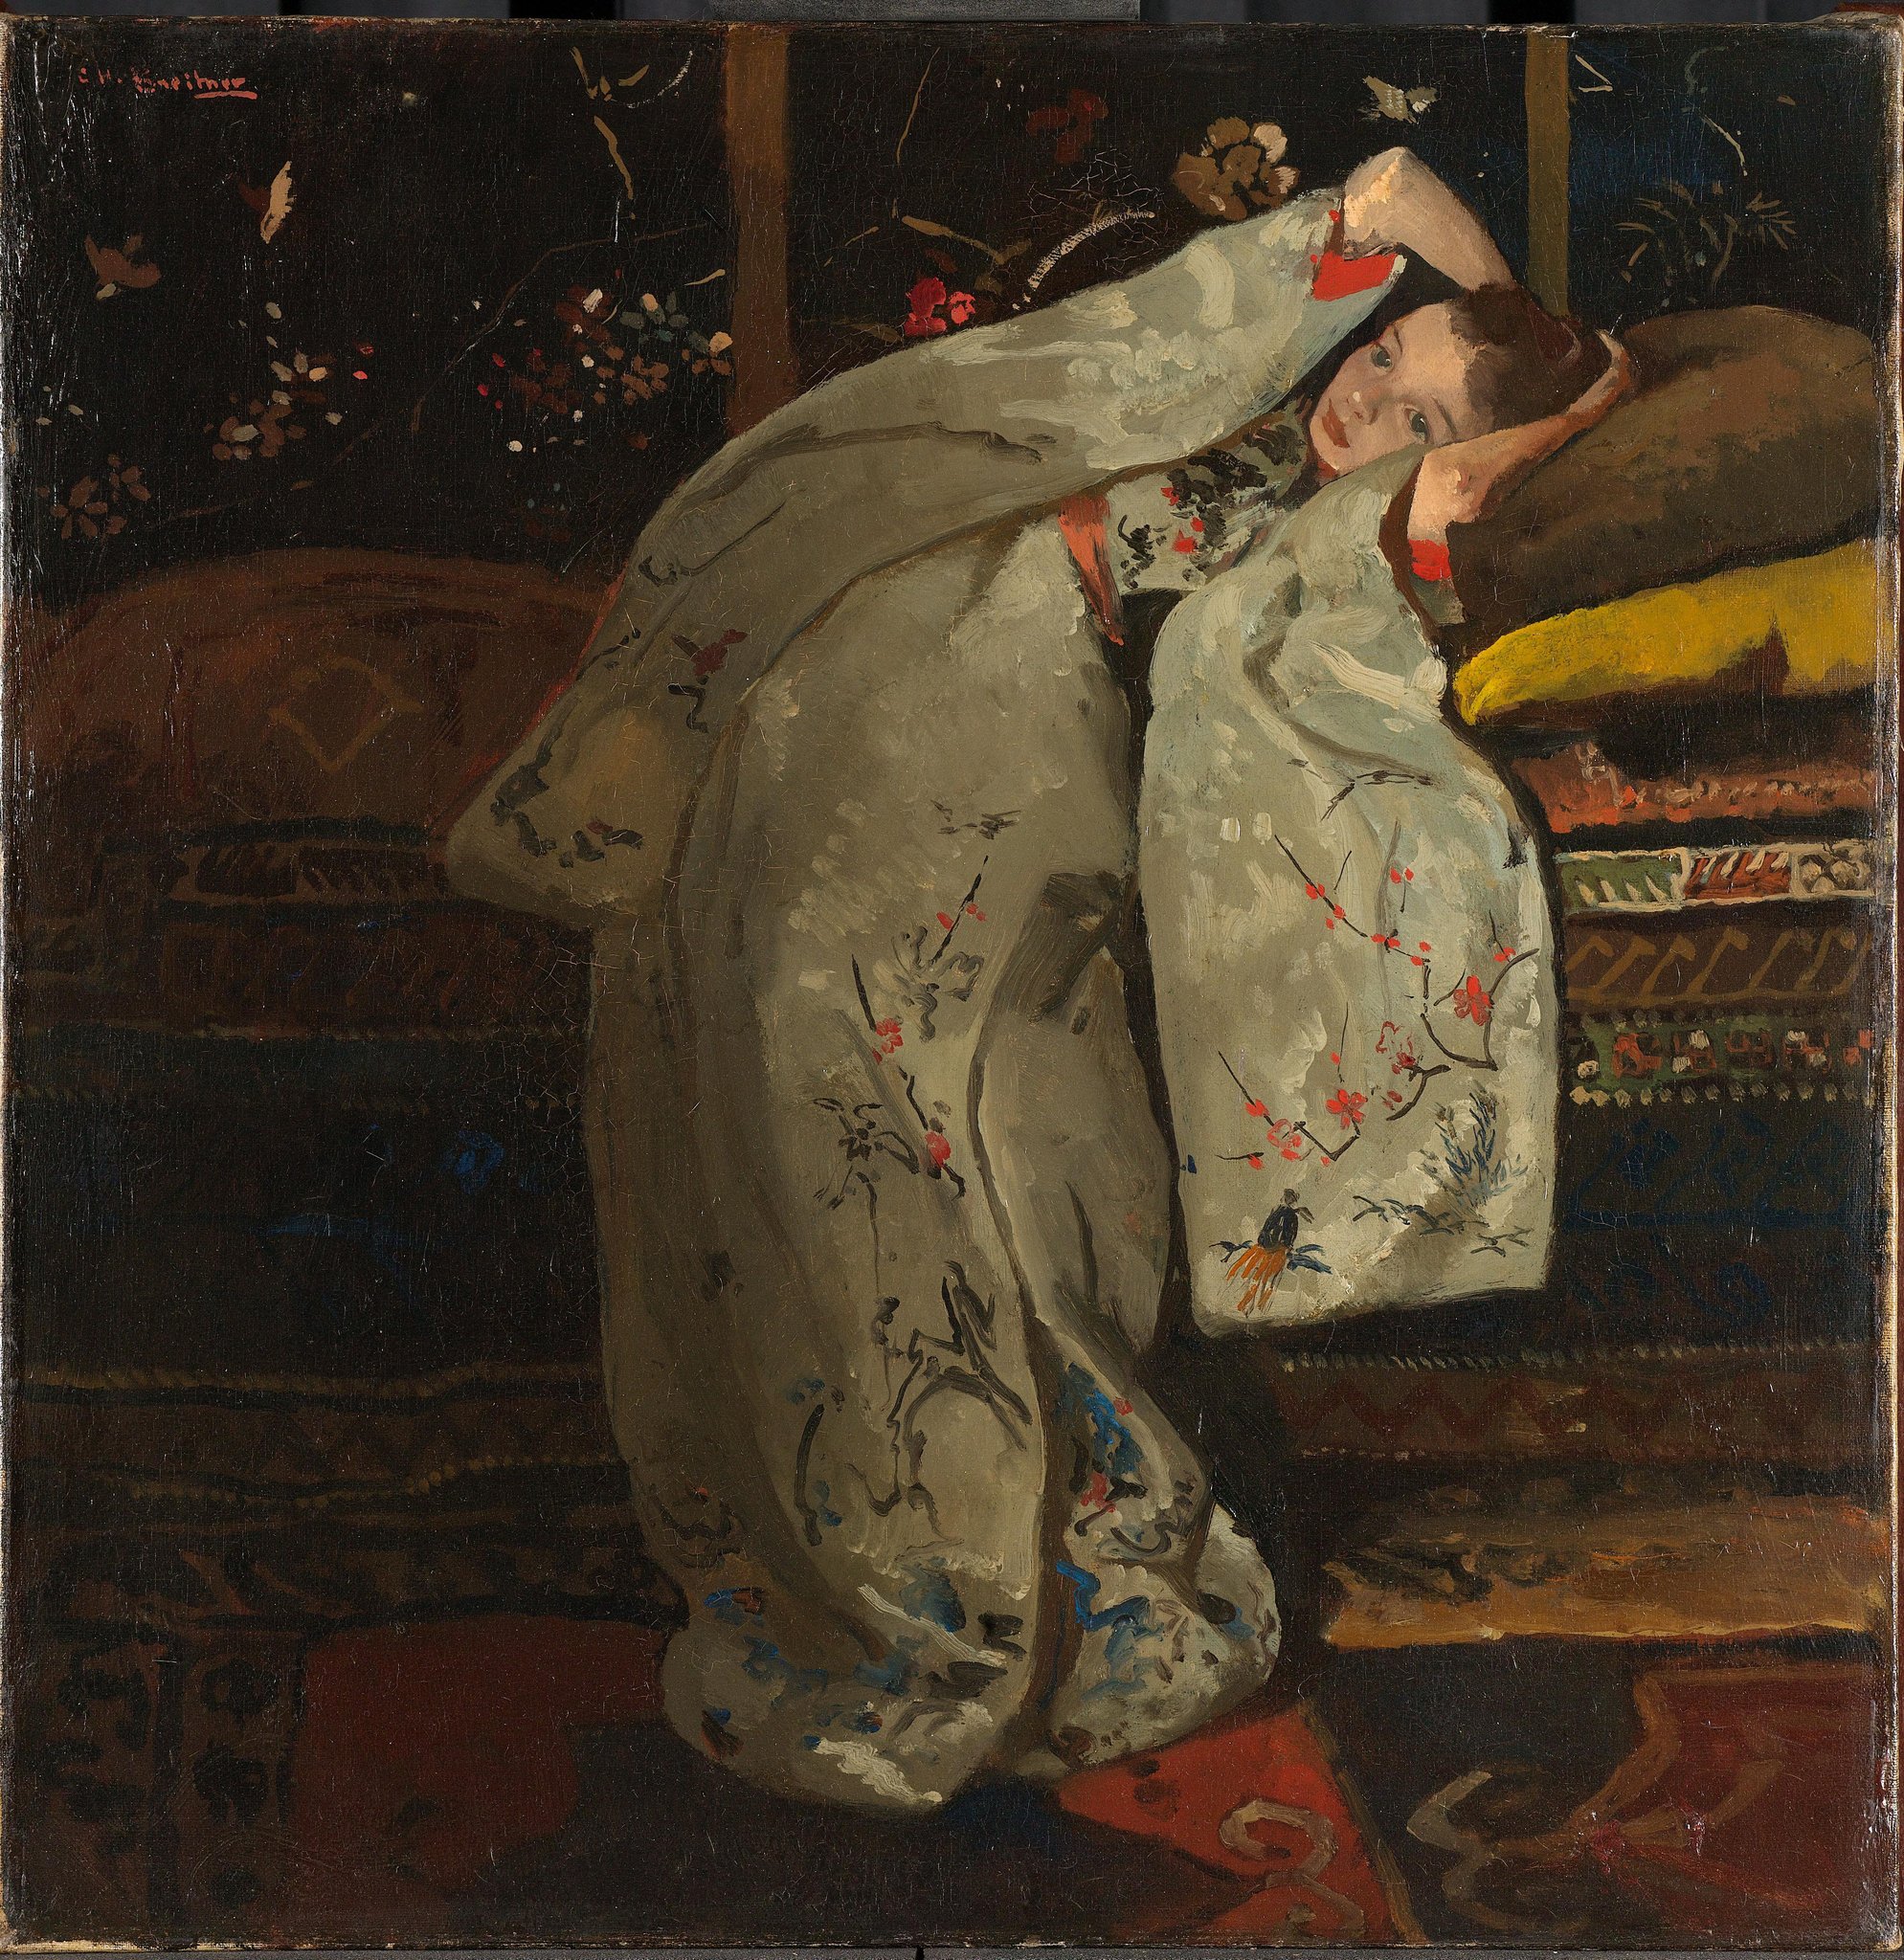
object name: painting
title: Girl in a White Kimono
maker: george hendrik breitner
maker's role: draughtsman, painter, print maker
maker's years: 1857-1923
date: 1894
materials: canvas, oil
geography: amsterdam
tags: artist's model, sitter, historical persons - bb - woman, dress, gown (+ women's clothes), screen, folding screen, lying figure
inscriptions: signature: ‘G.H. Breitner’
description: The model for this painting was called Geesje Kwak, then a sixteen-year-old housemaid from Amsterdam. She is dressed in a Japanese kimono, a popular subject for Breitner. He made thirteen paintings of girls in kimonos, inspired by Japanese prints, which he as well collected. However, for Europeans, wearing Asian clothing since long also had a sexual inference.